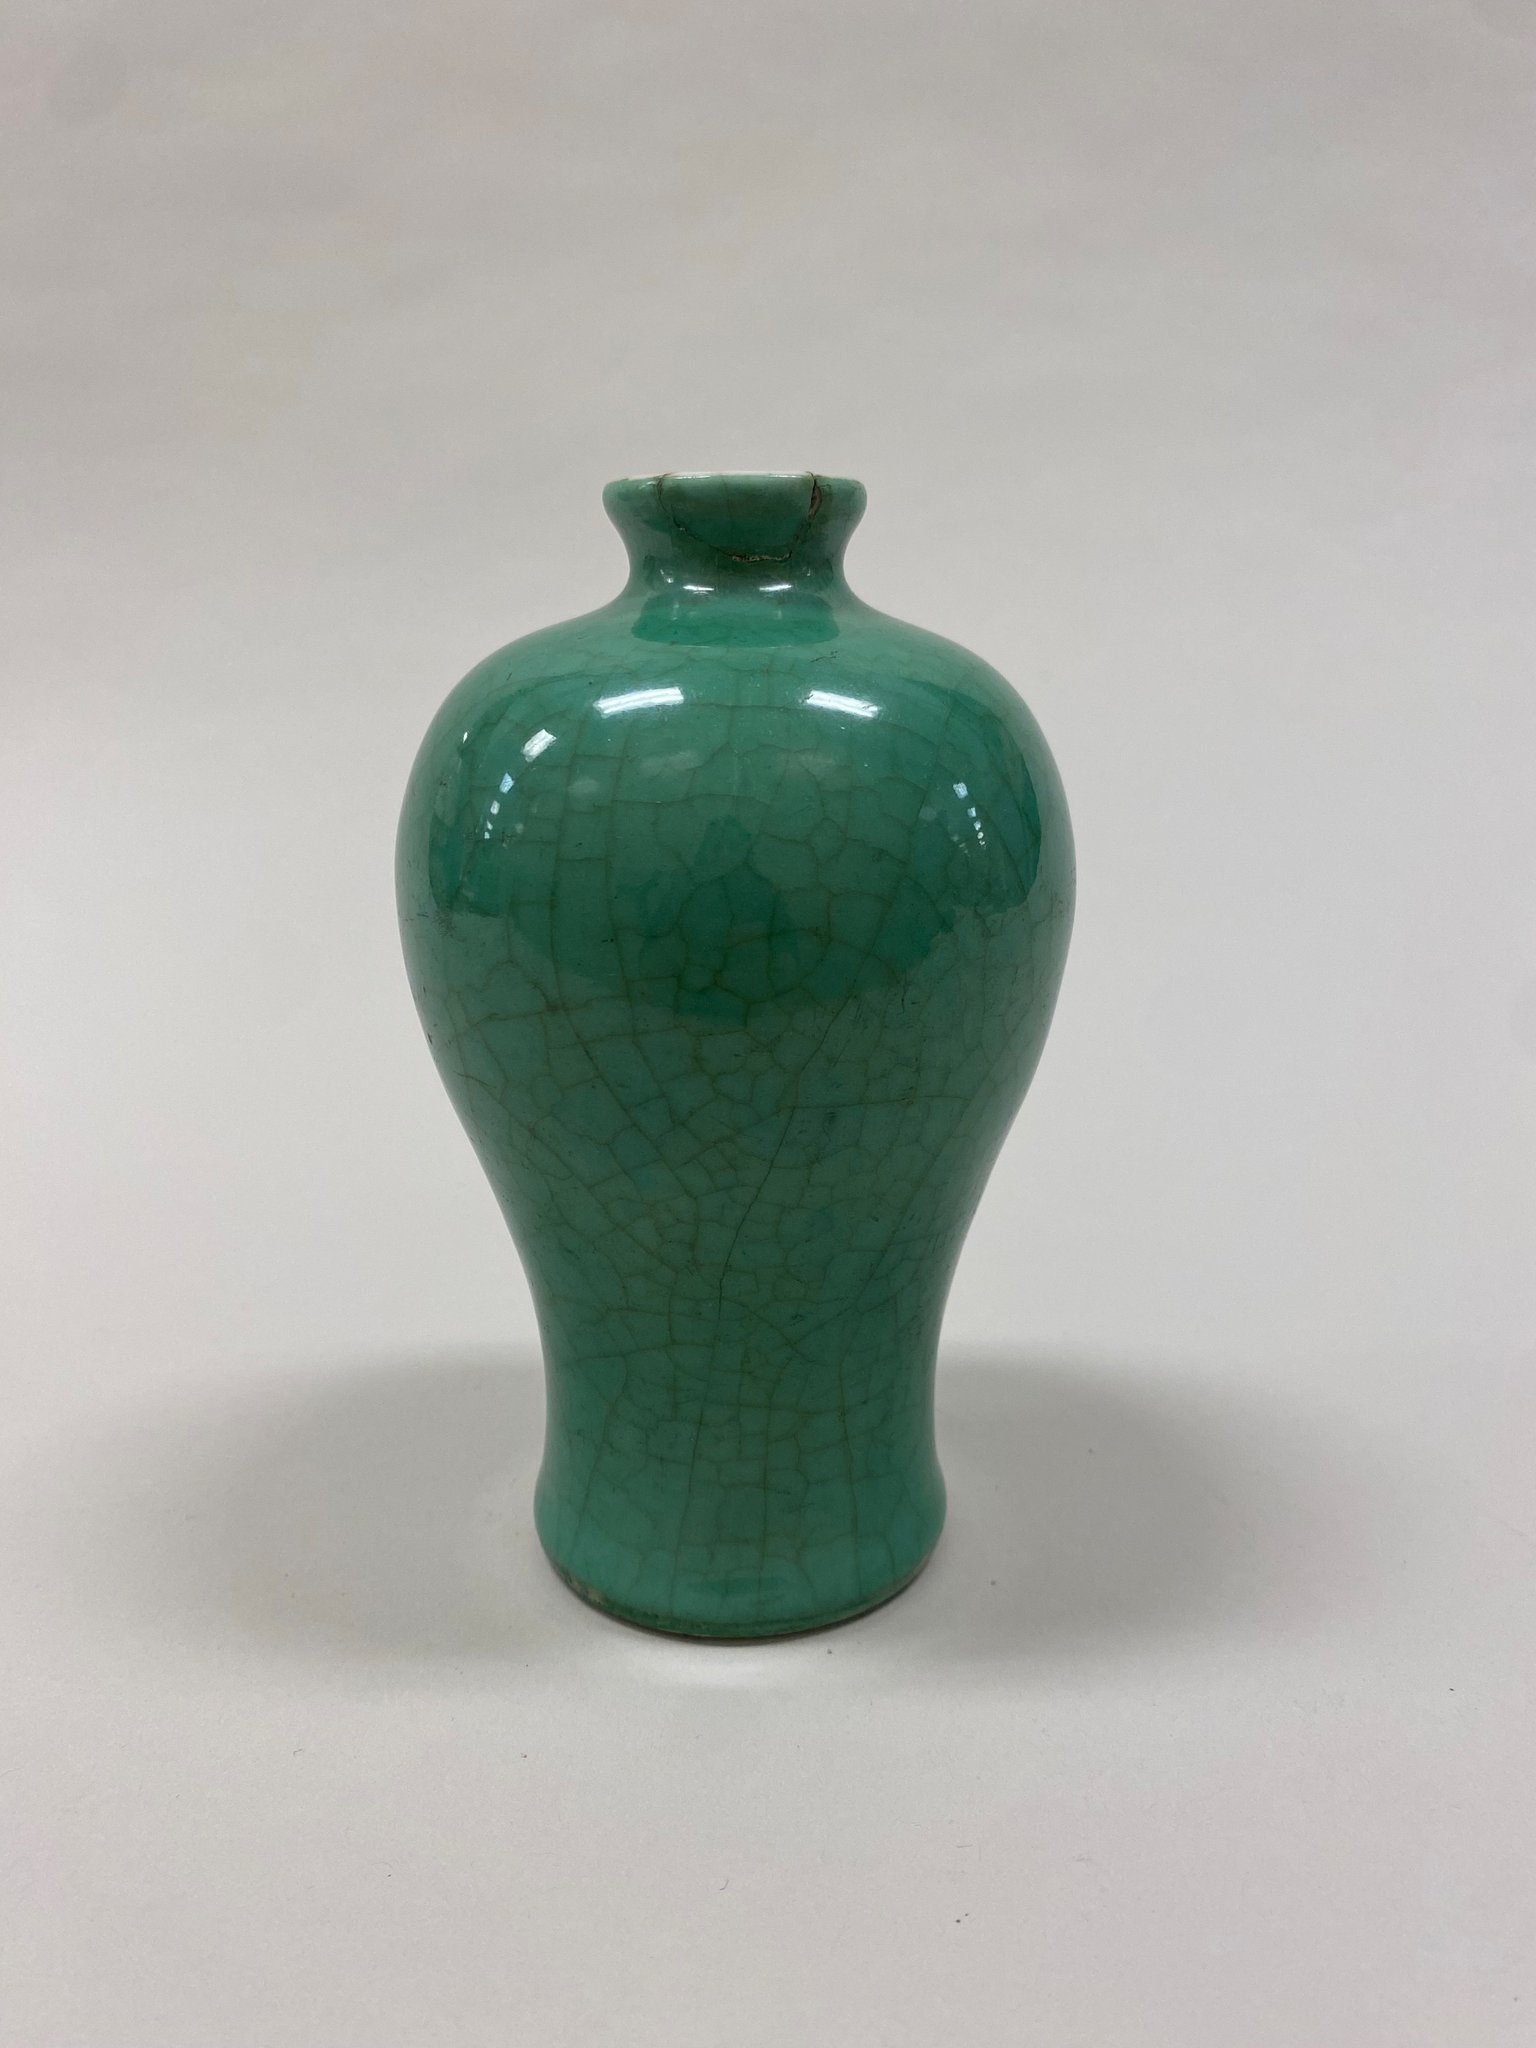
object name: vase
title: Meiping vase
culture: chinese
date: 1701-1733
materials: glaze, porcelain